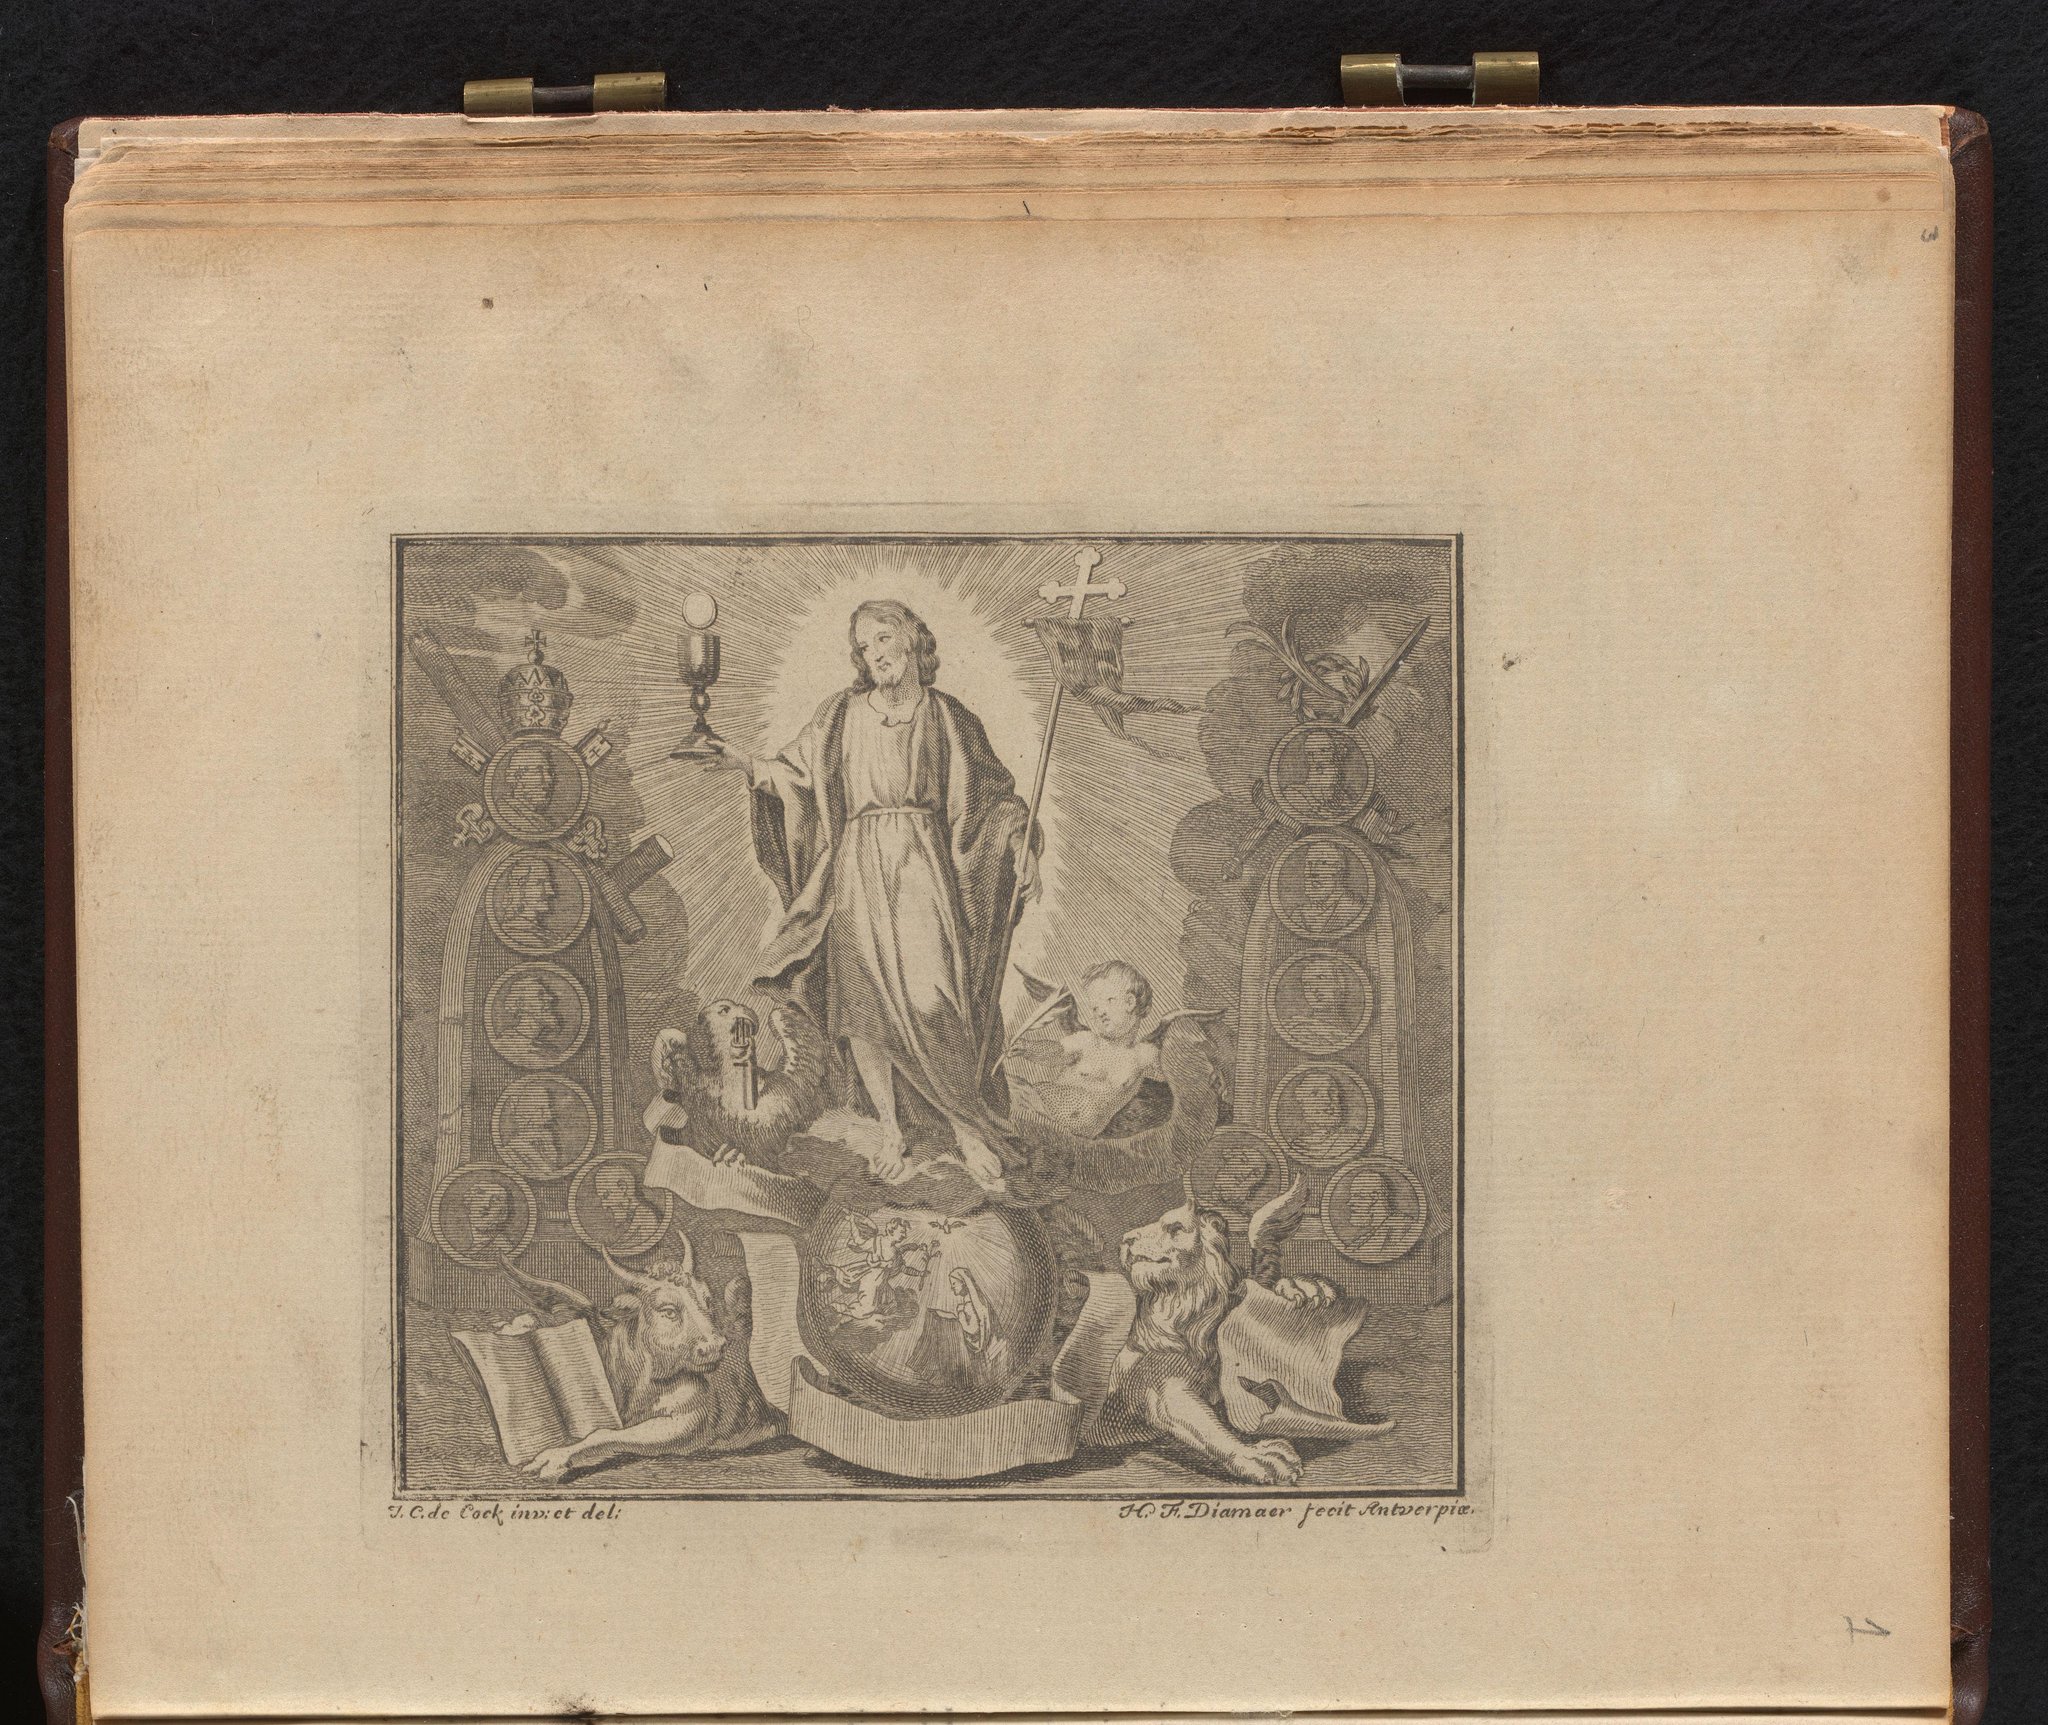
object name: print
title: Allegorie op het katholieke geloof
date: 1695-1736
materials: paper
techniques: engraving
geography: antwerp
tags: christ with chalice, and bread or host, the four symbols of the evangelists, 'the apocalyptic beasts', the twelve apostles (as a group), usually with books or scrolls (not in biblical context), diadem, tiara, the annunciation: mary, usually reading, is visited by the angel (sometimes a woman overhears the conversation)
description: Prent in: s.n. Aldernouwkeurigste verhandelinge der geschiedenissen van het Nieuw Testament (...). Antwerpen: Cornelis Marten Spanoghe, 1783, p. 1.